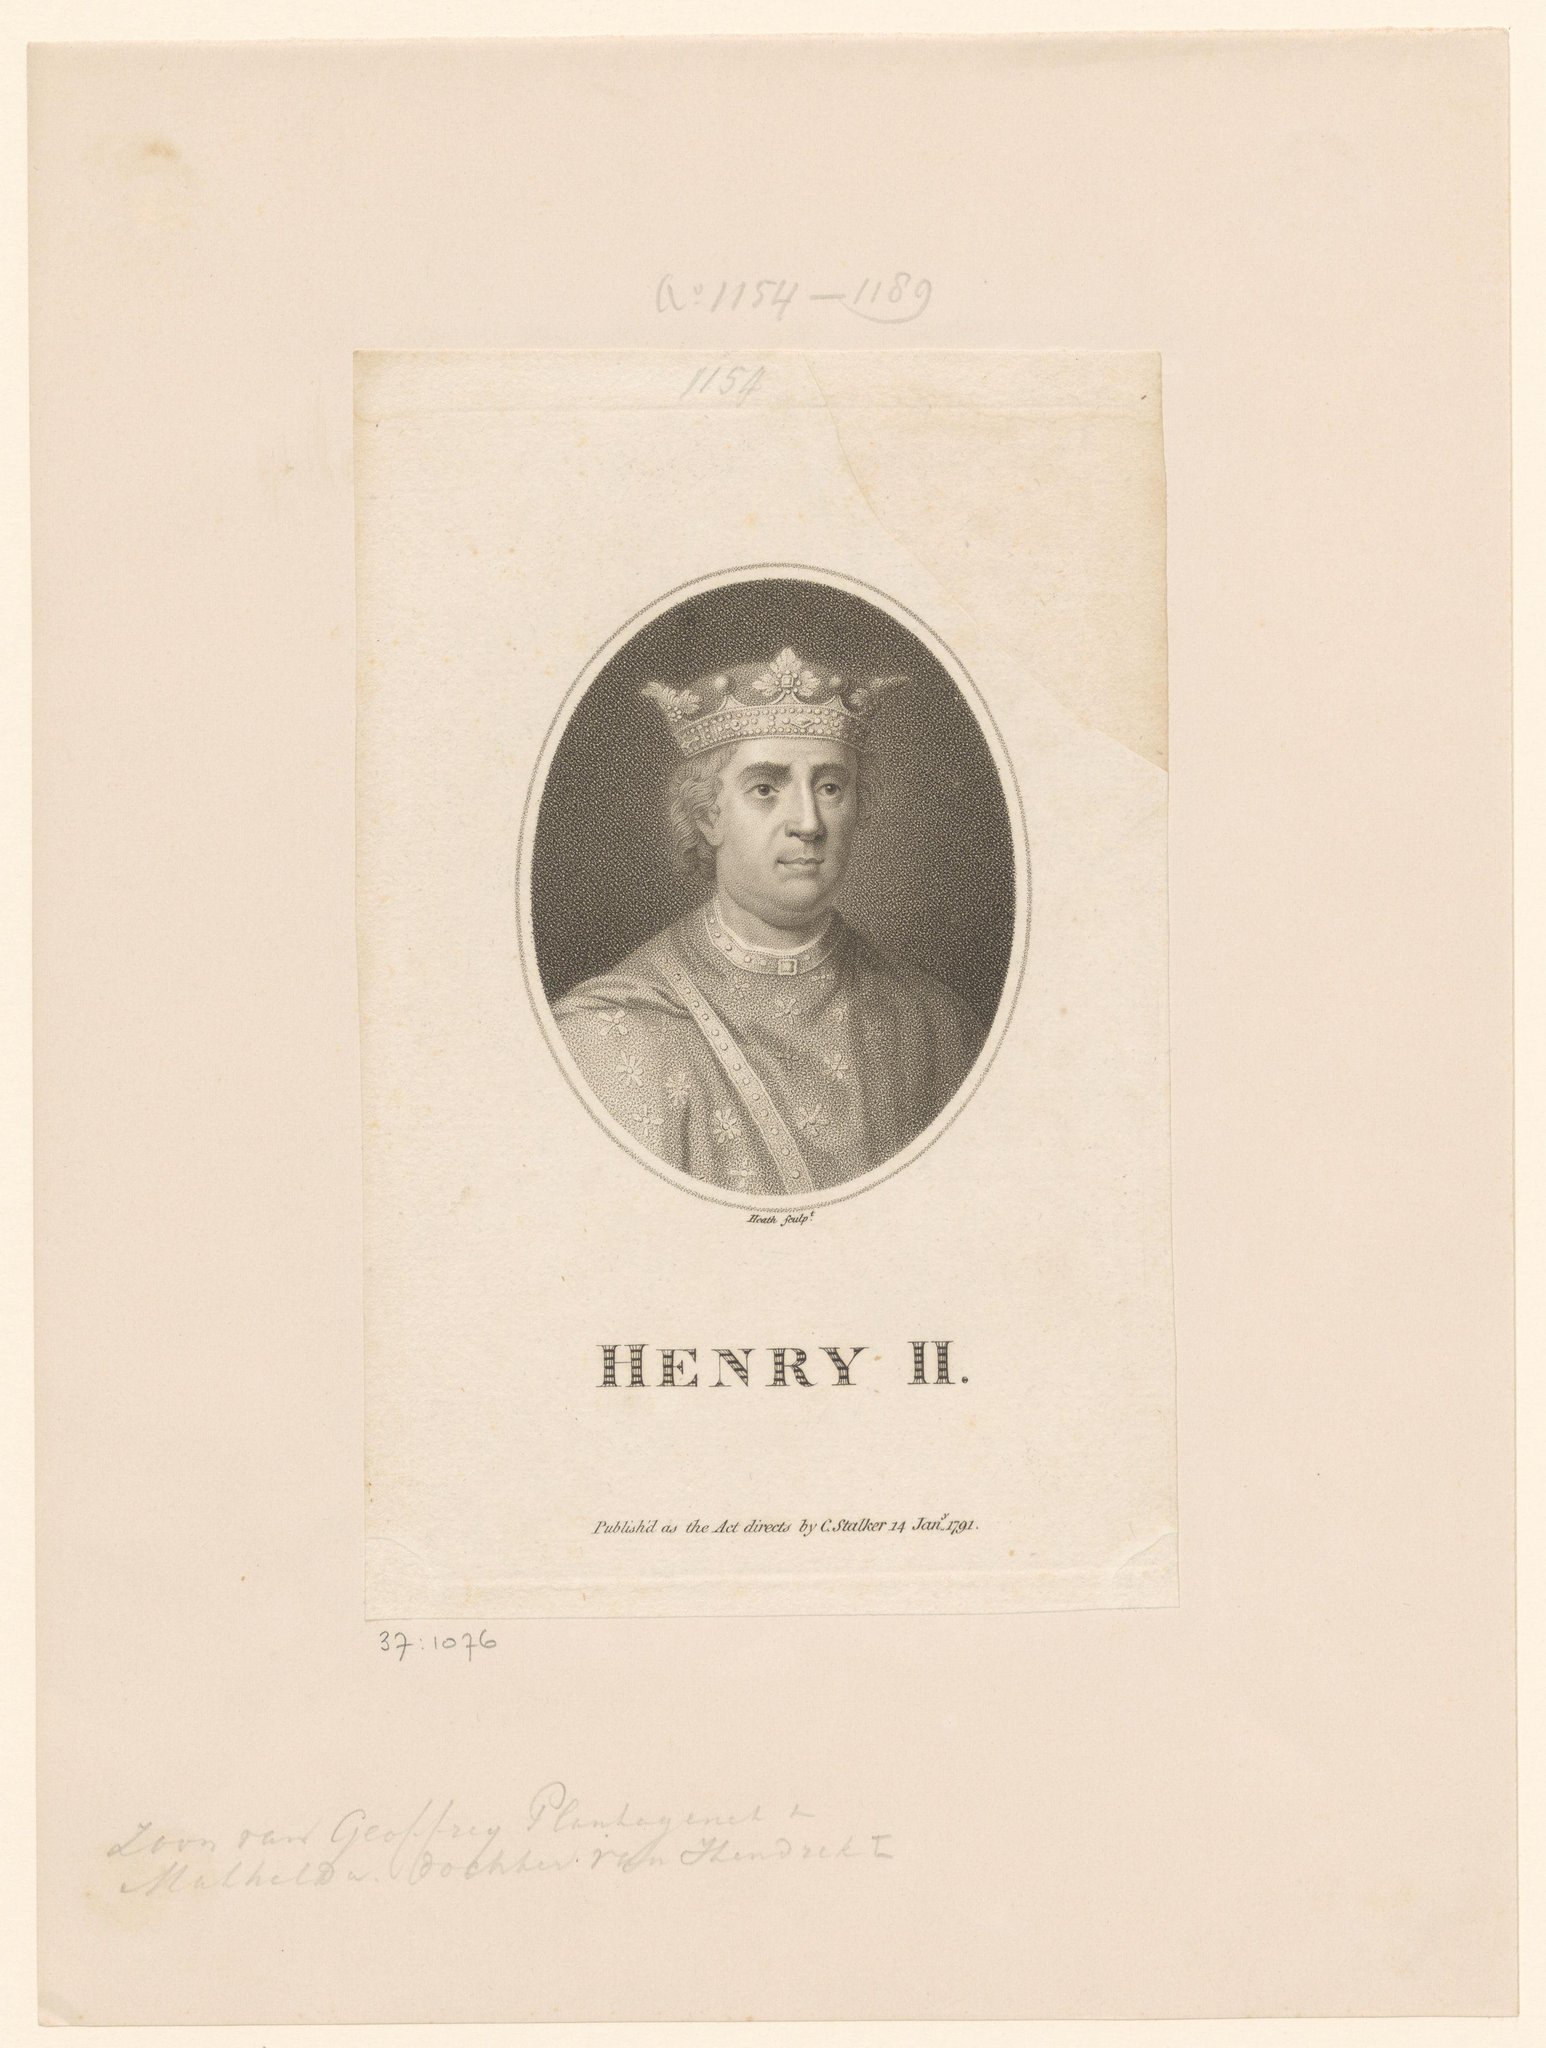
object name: print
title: Henry II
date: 1701-1791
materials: paper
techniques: stippling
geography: london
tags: historical persons, king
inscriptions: collector's mark: Lugt 2228